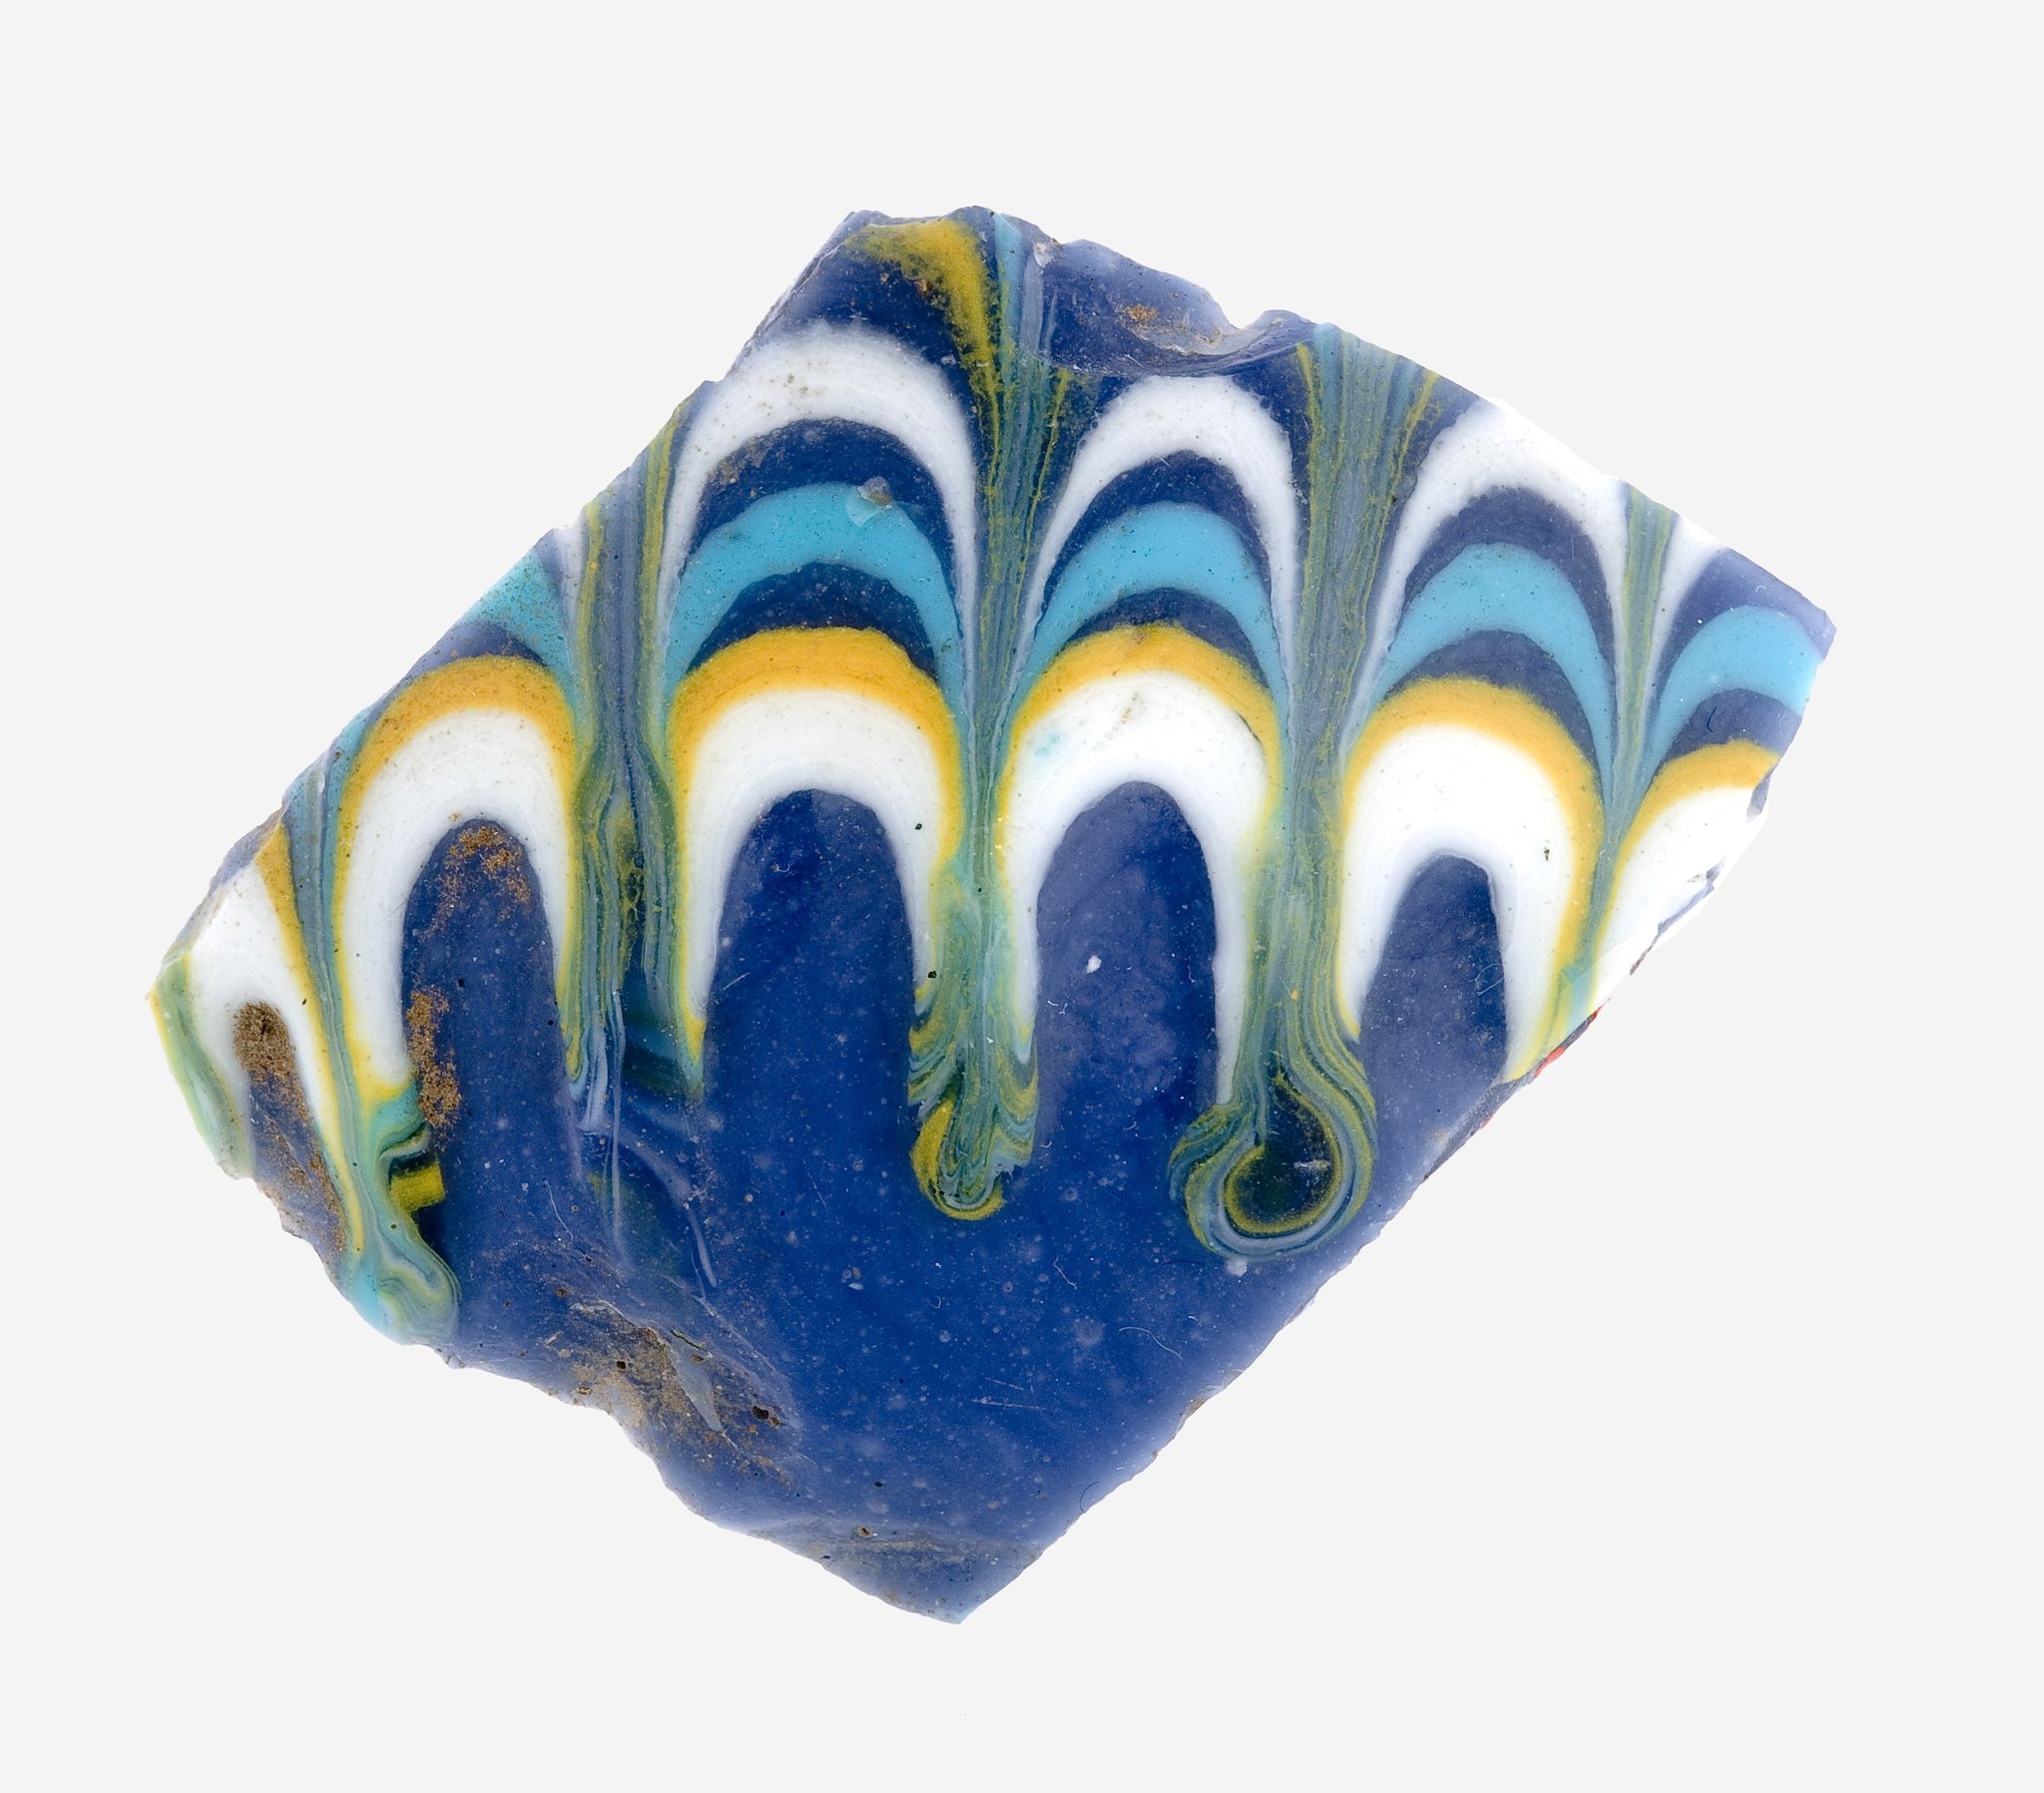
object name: vase fragment, festoon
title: Shoulder Fragment of a Vase with Festoon Pattern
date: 1390-1352 BCE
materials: glass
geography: egypt